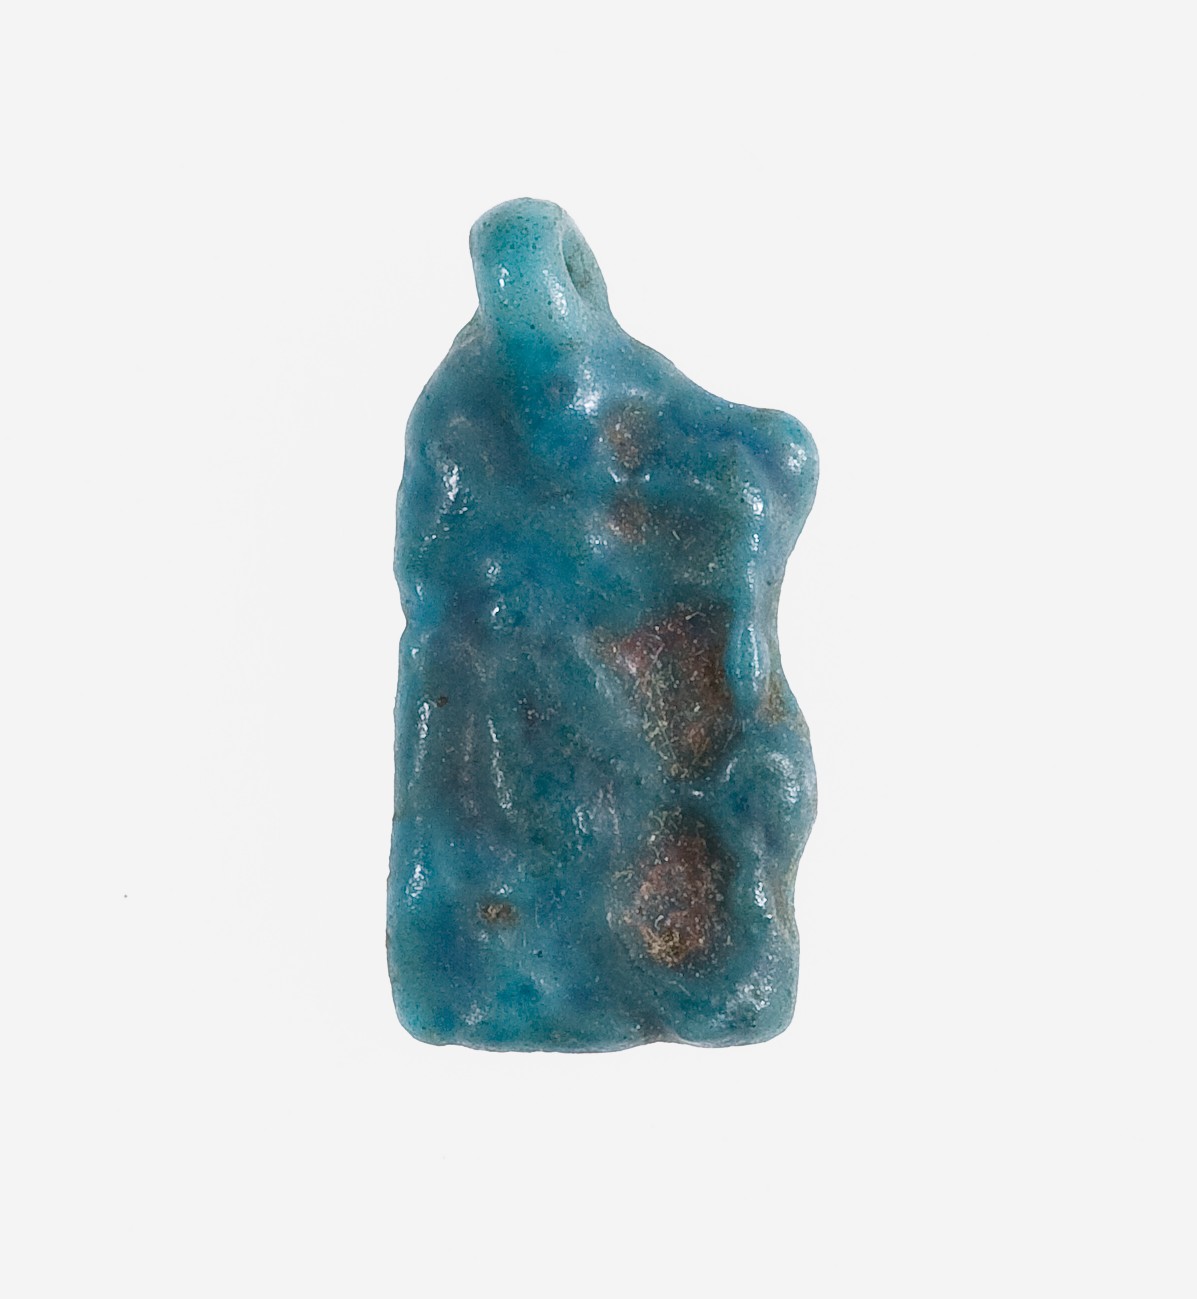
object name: amulet, taweret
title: Taweret Amulet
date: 1390-1352 BCE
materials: faience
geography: egypt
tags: taweret